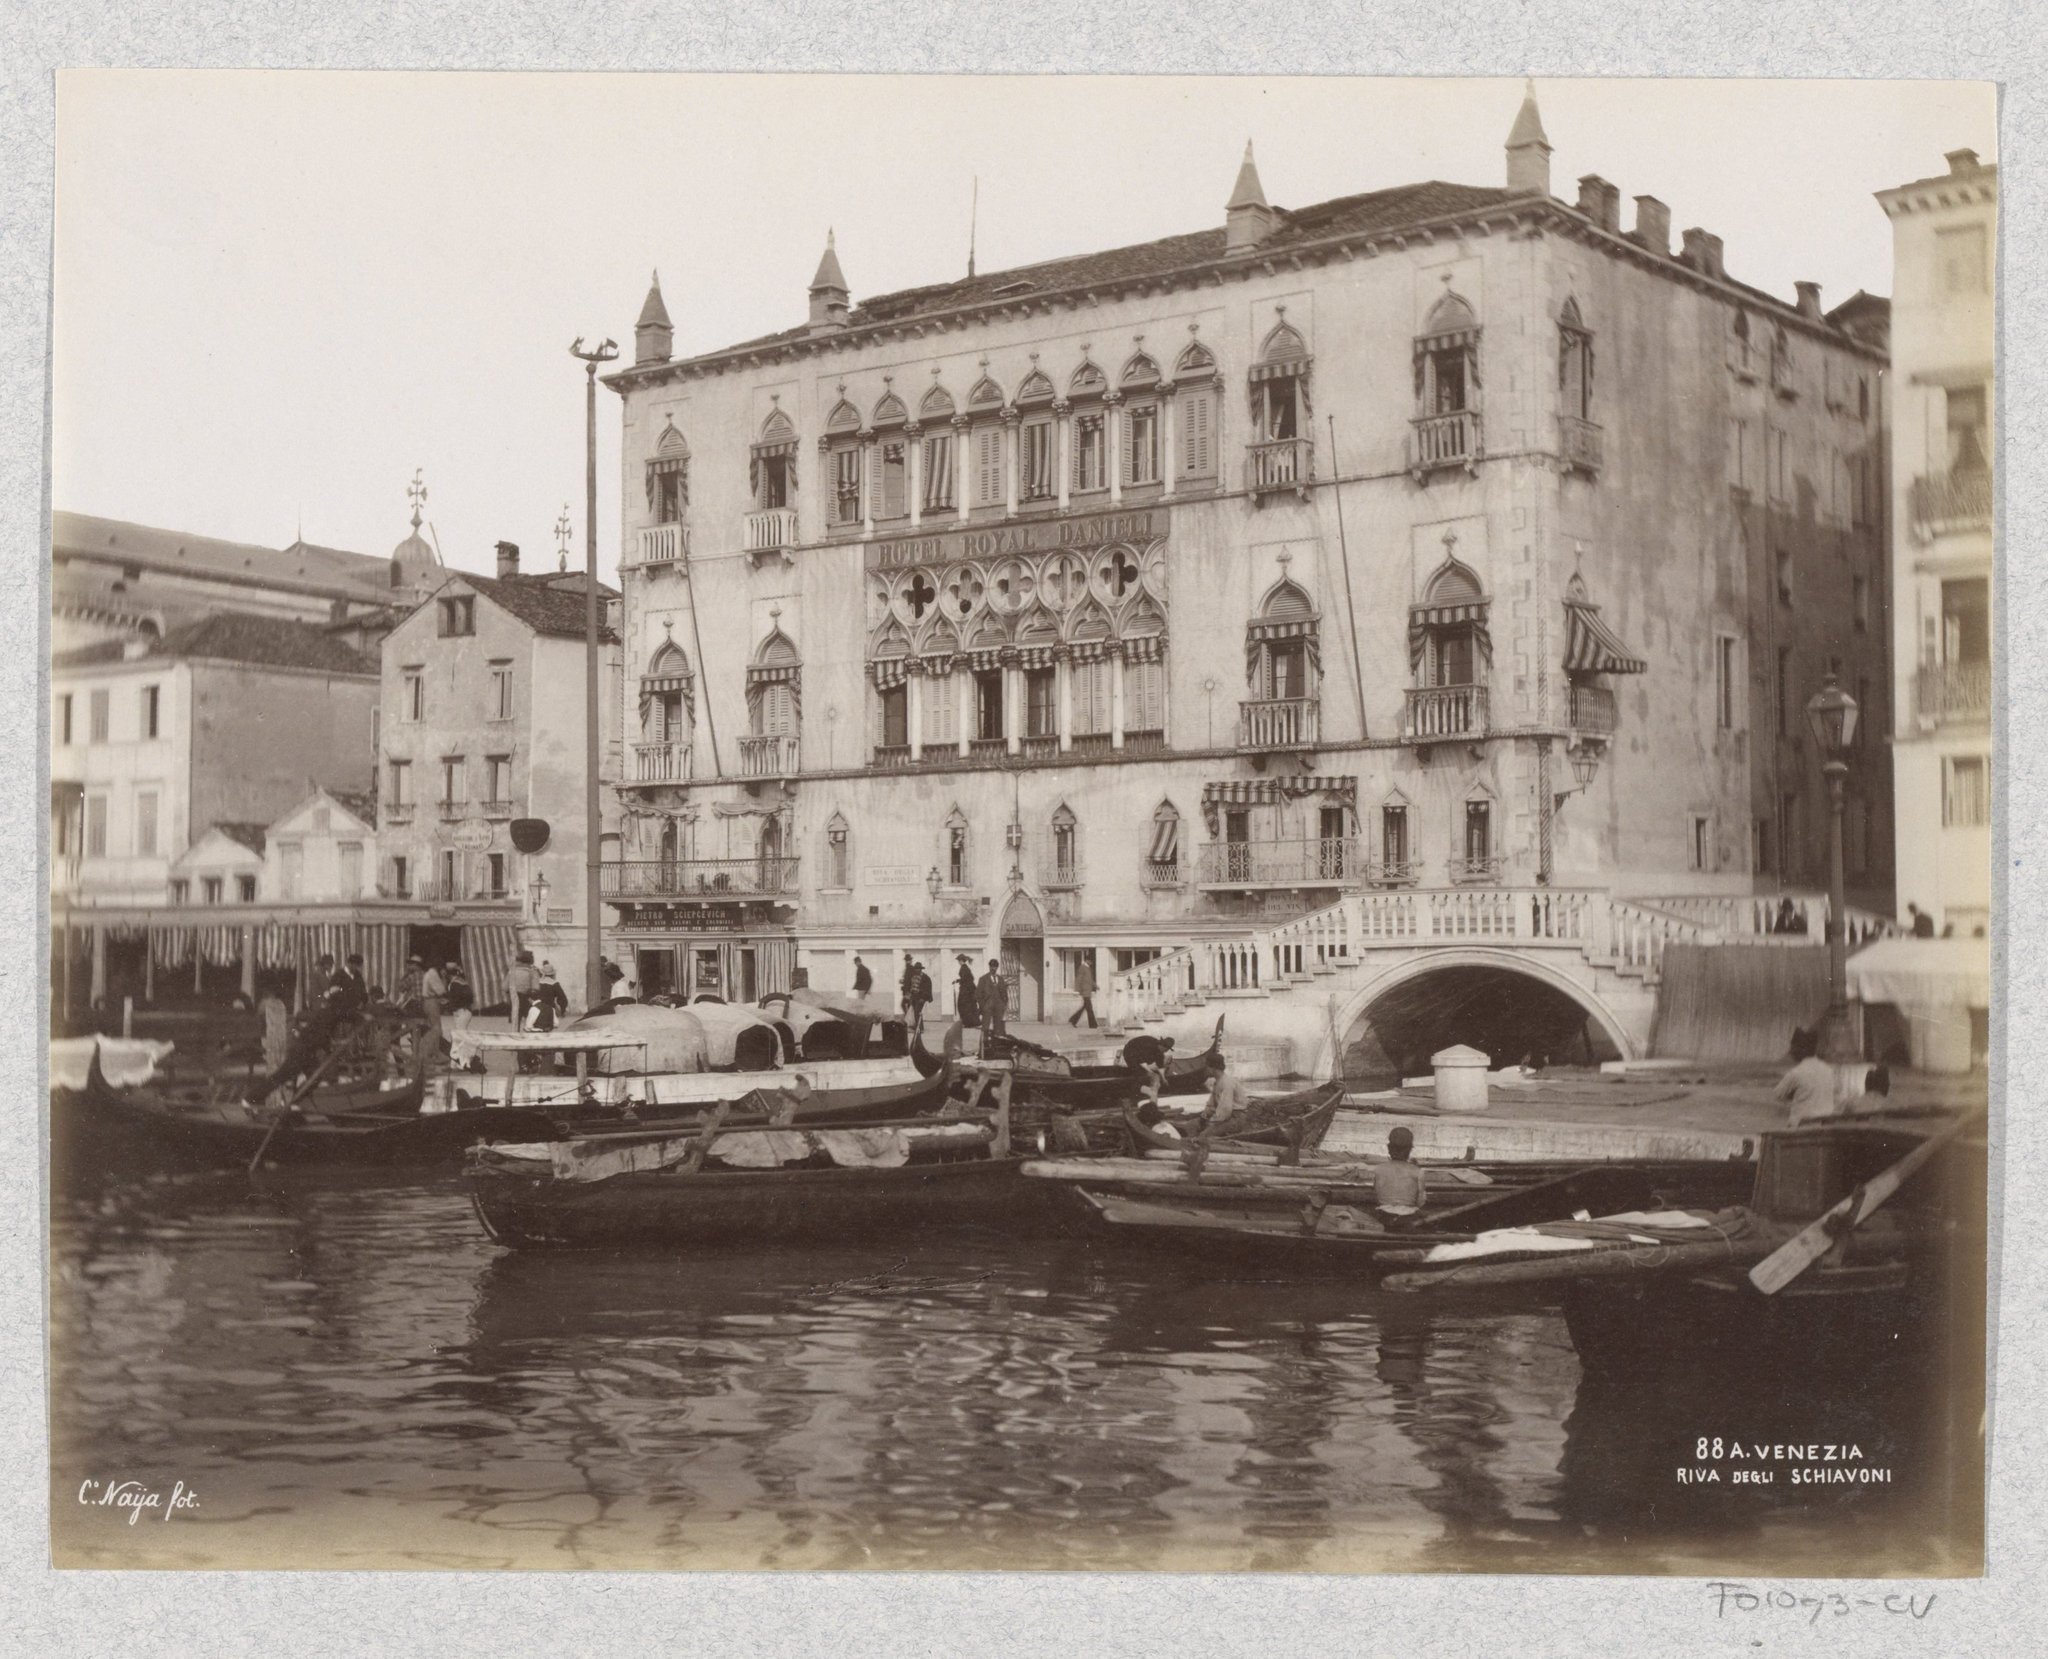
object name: photograph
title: Hotel Royal Danieli in het Palazzo Dandolo en boten aan de Riva degli Schiavoni in Venetië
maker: carlo naya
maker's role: fotograaf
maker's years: 1816-1882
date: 1870-1890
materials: paper, photographic support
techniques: albumen print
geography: venice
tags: palace, hotel, hostelry, inn, venice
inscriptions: negative number: ‘88A.’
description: Onderdeel van Reisalbum met foto's van bezienswaardigheden in Genua, Florence en Venetië.